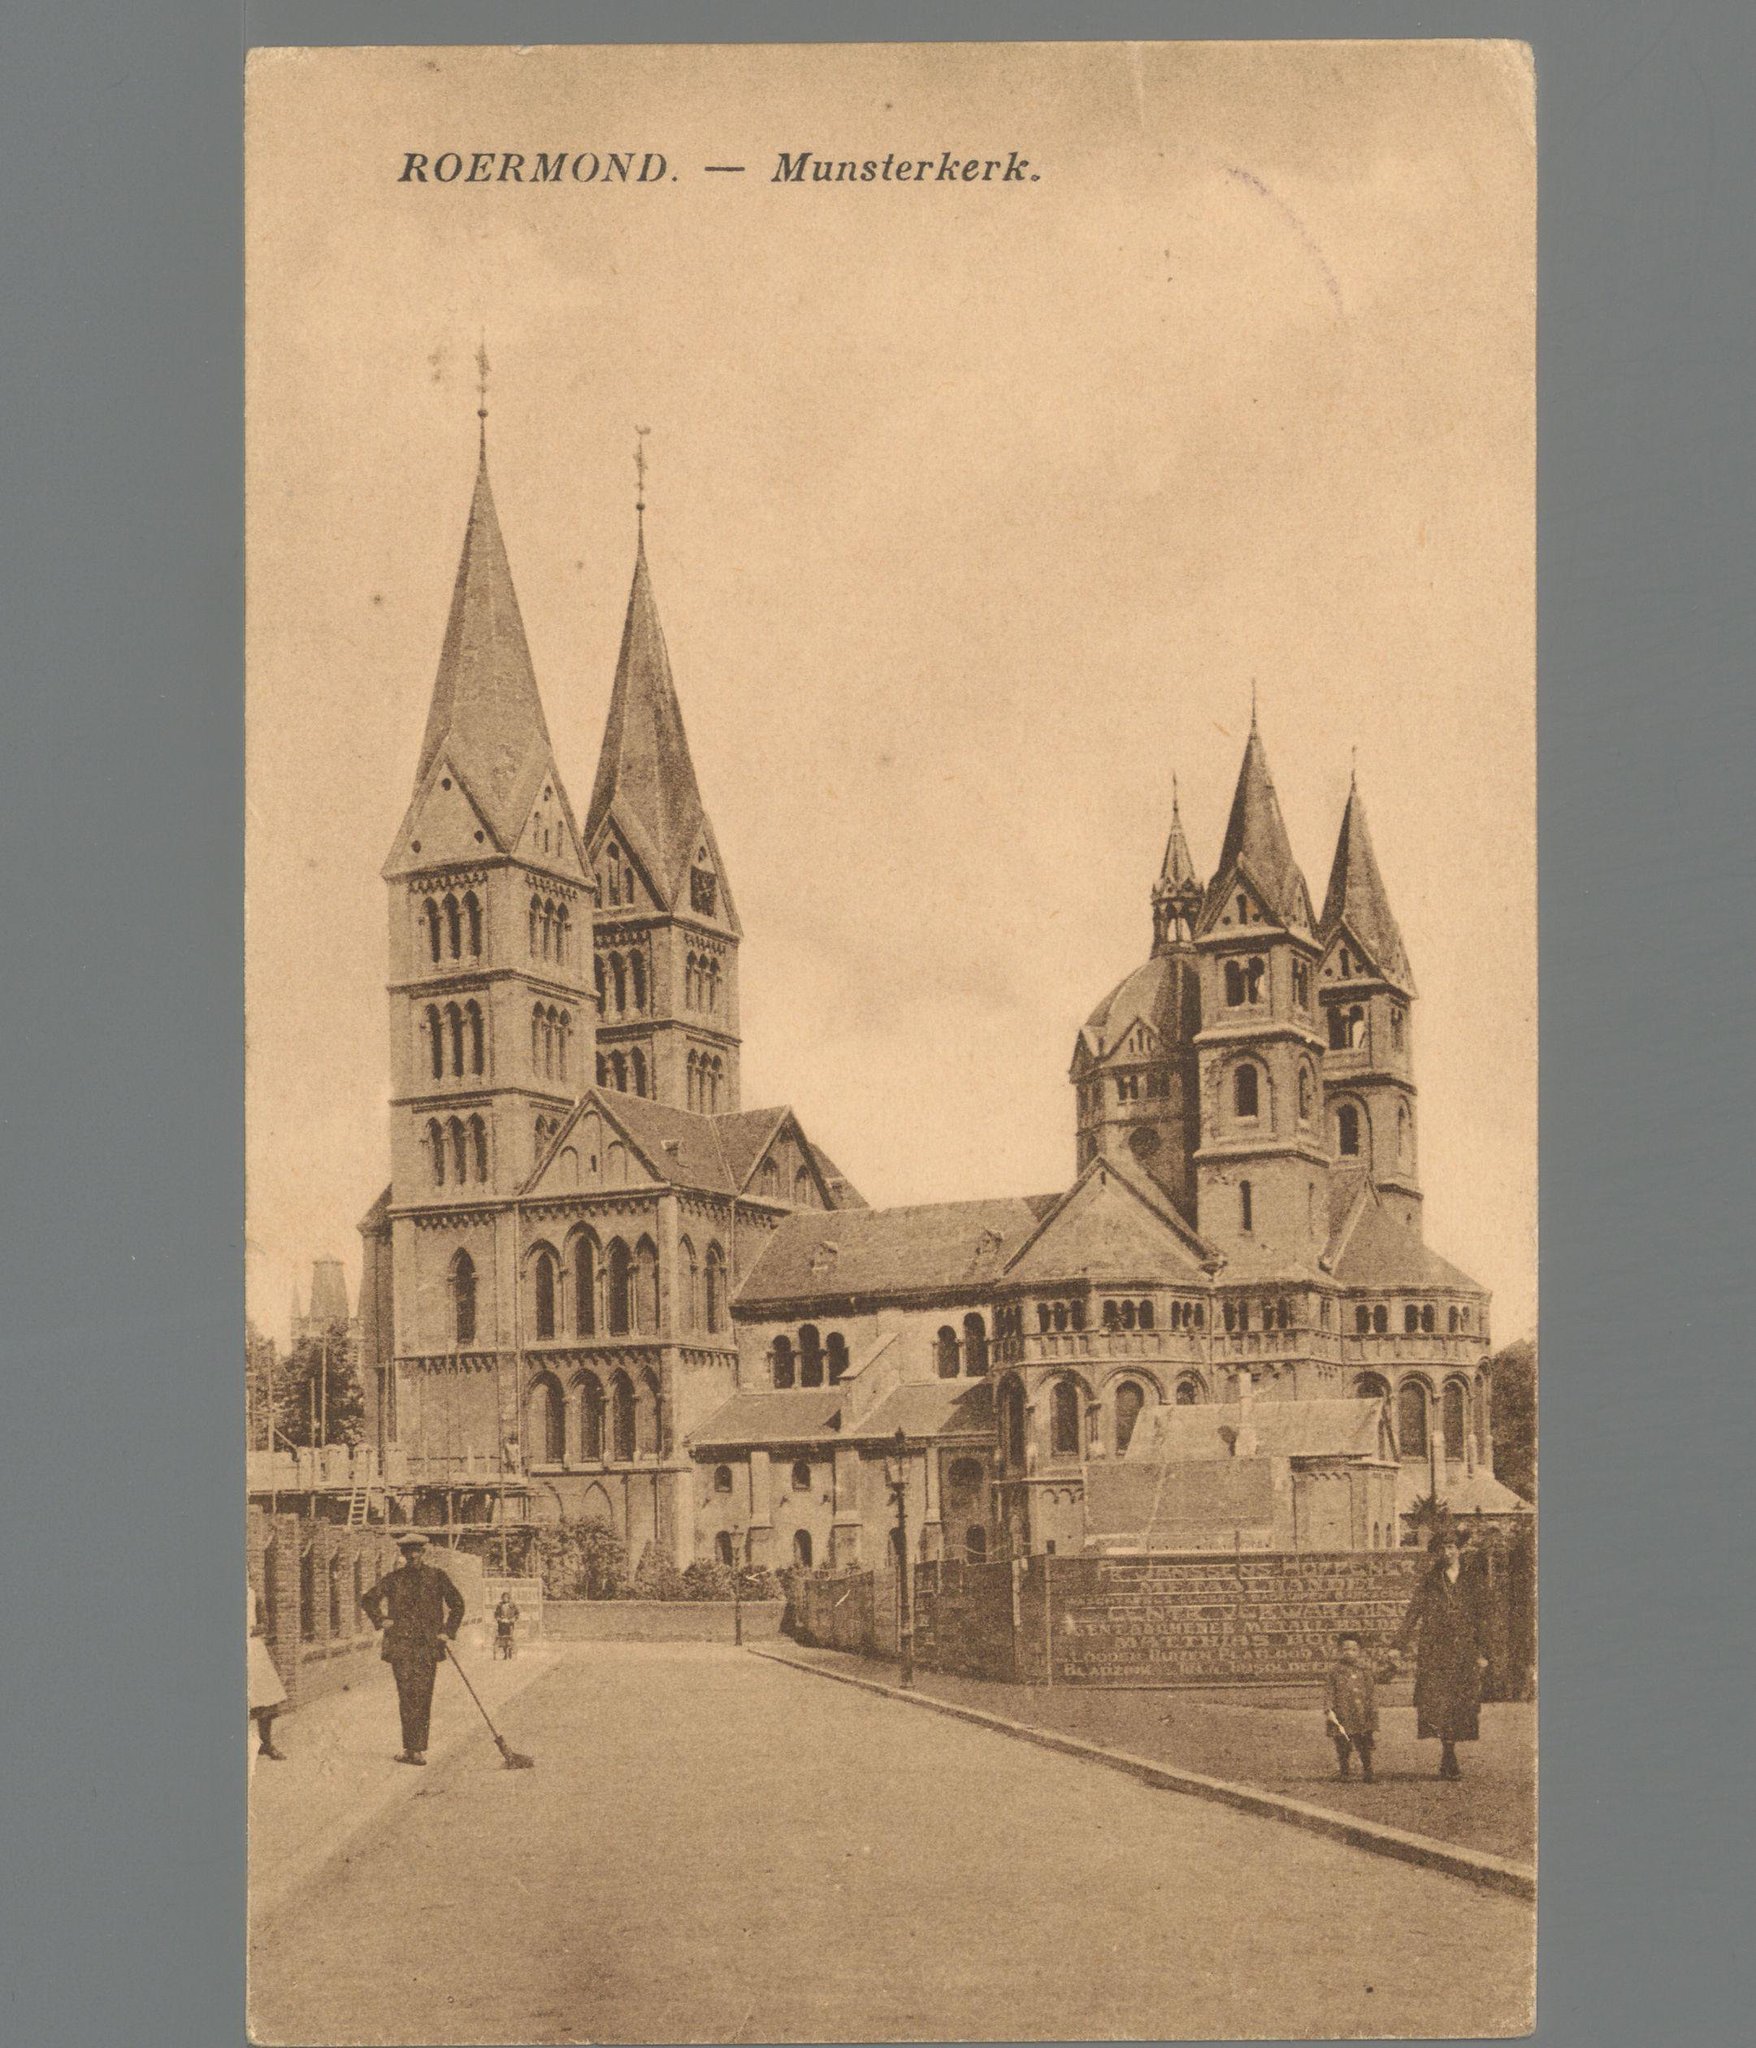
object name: ansichtkaart, prentbriefkaart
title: Roermond. - Munsterkerk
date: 1905-1923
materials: cardboard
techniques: photograph, writing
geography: roermond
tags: church (exterior)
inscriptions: poststempel, verso, gestempeld